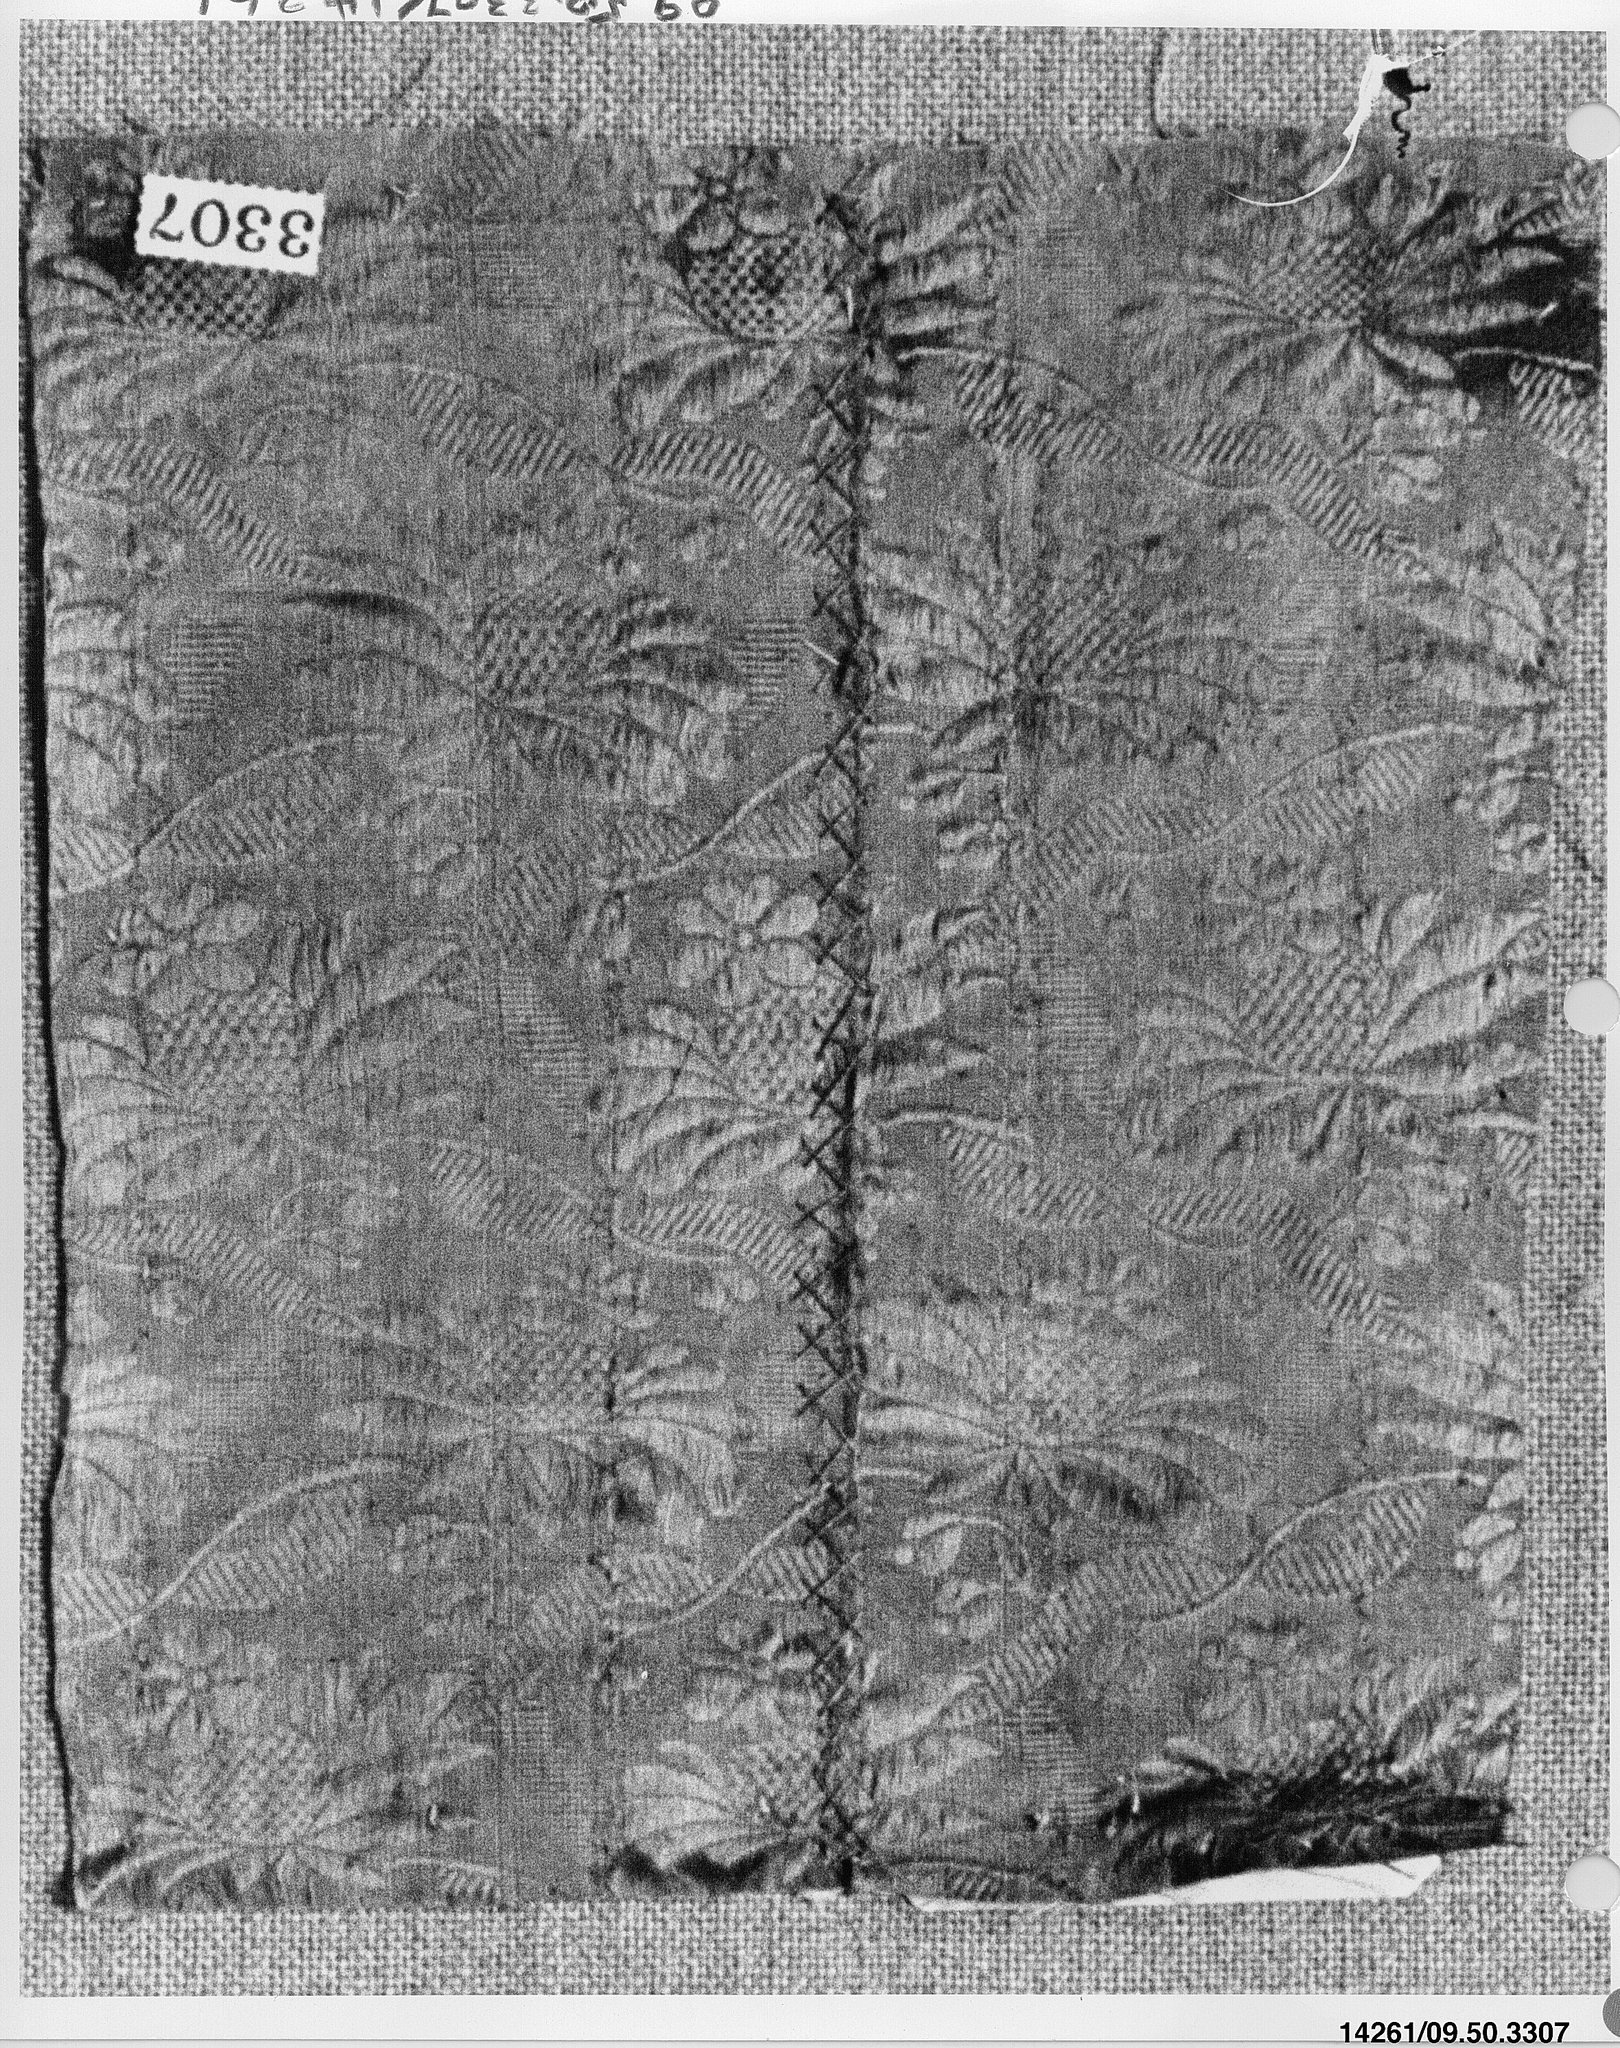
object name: piece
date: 1701-1800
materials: silk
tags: flowers,leaves